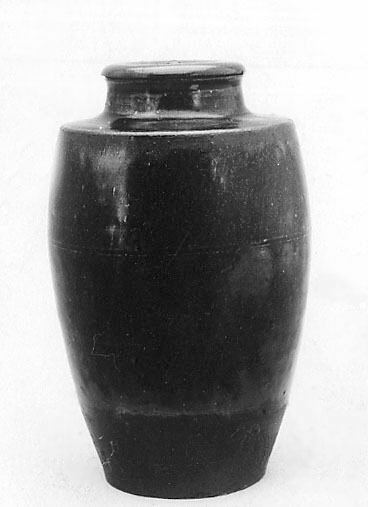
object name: tea jar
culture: japanese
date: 1701-1800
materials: clay, glaze